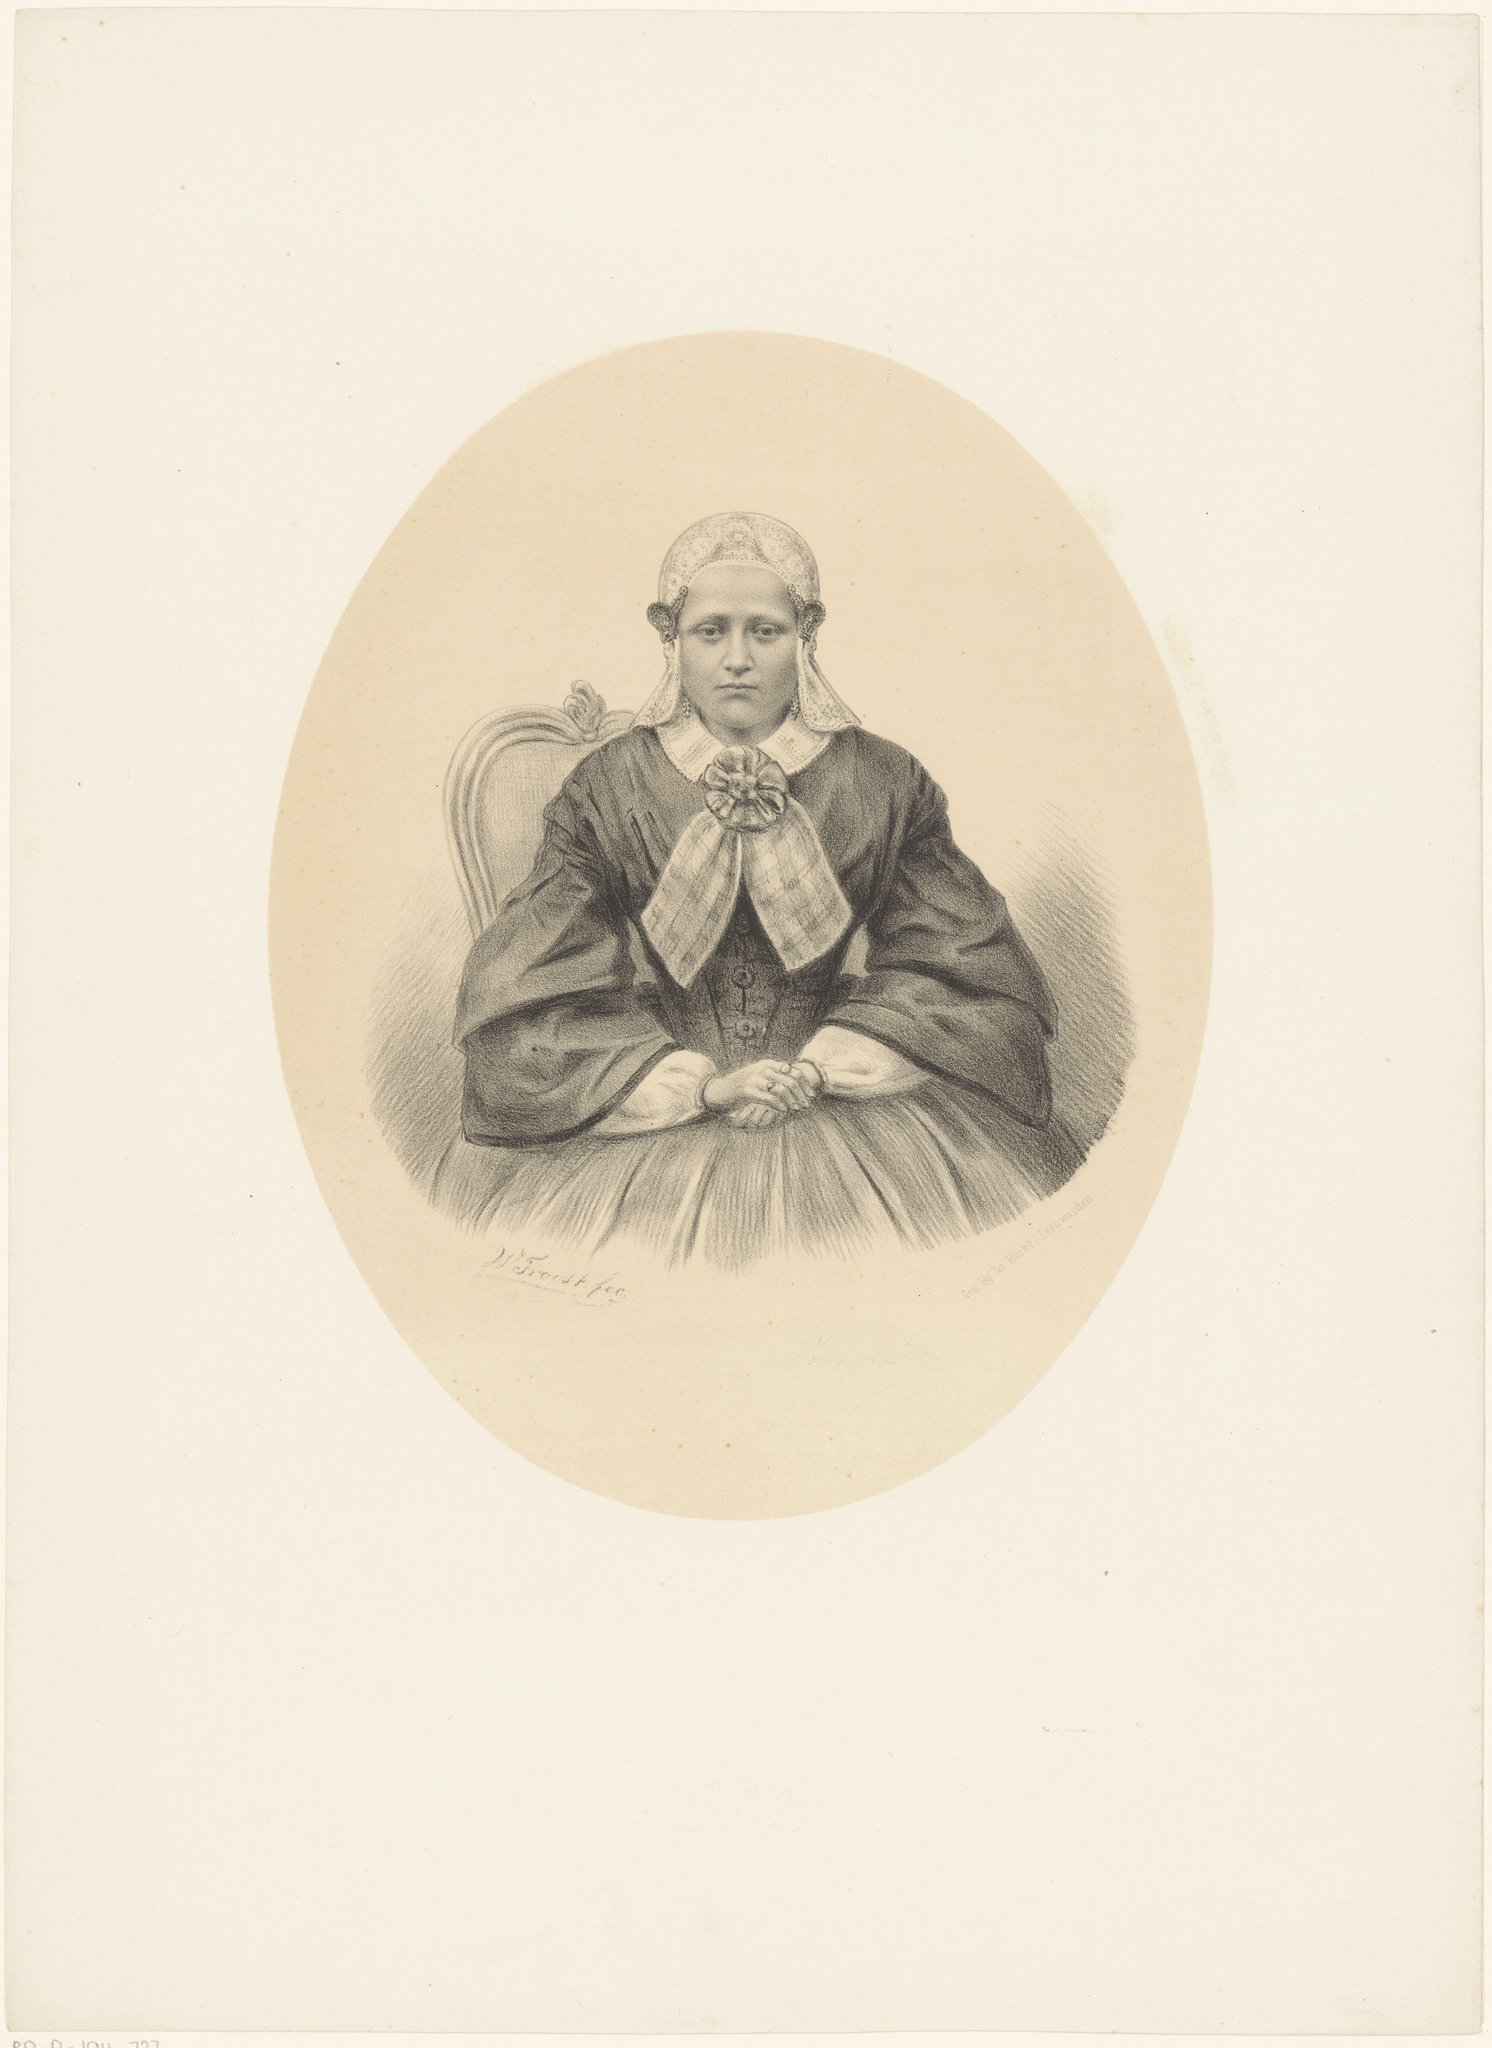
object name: print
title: Portret van onbekende vrouw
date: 1822-1893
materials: paper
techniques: tone lithography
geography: leeuwarden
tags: anonymous historical person portrayed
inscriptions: collector's mark: Lugt 2228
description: Een jonge vrouw zittend op een stoel. In ovaal.